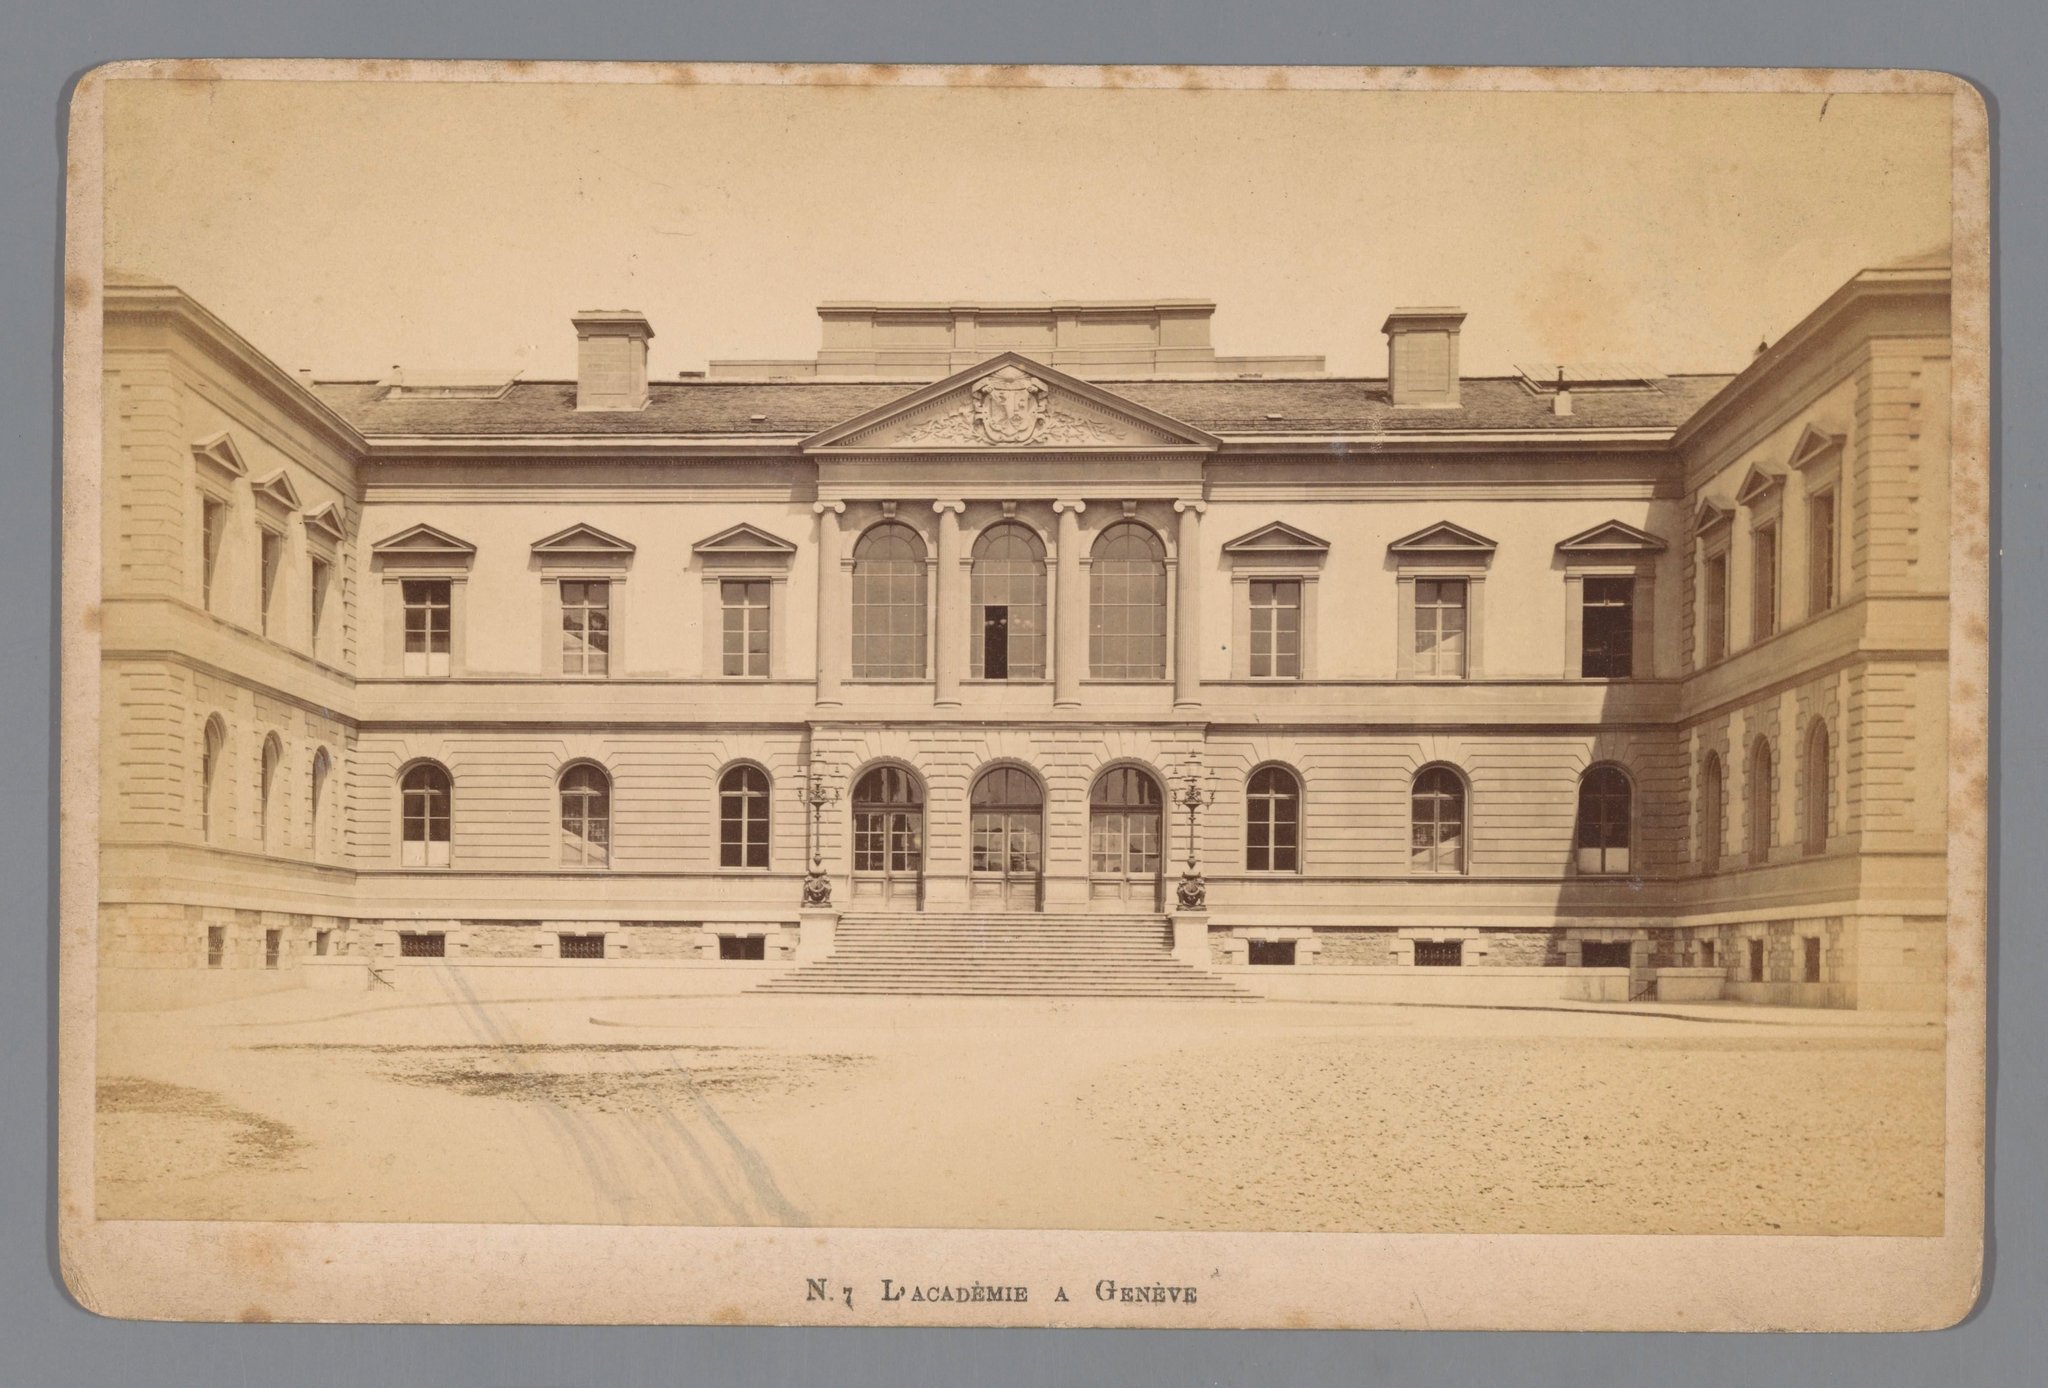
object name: photograph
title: Académie a Genève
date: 1880-1920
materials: cardboard, photographic support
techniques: albumen print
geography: geneva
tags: university building, college